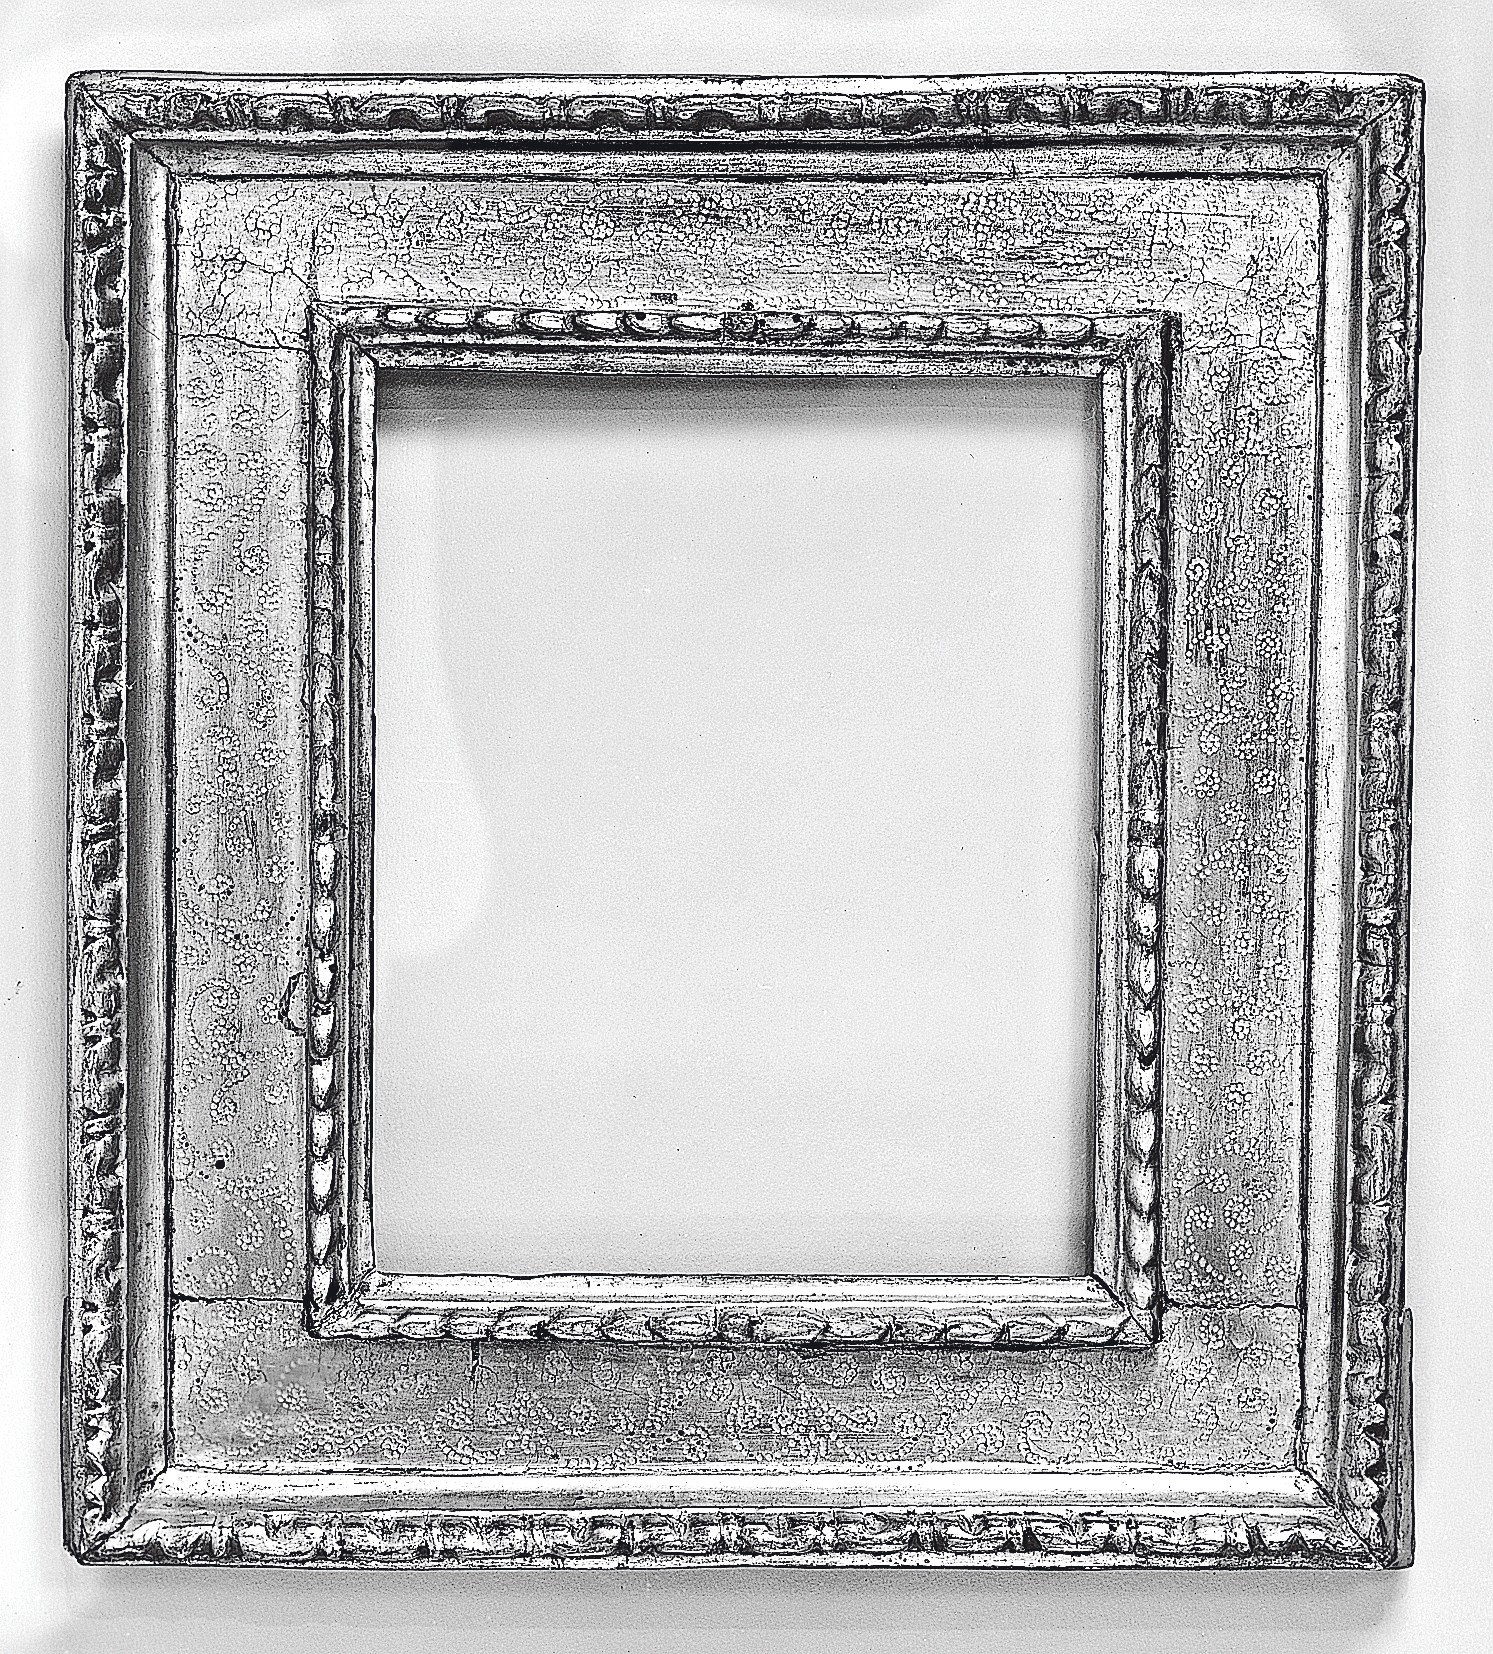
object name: frame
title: Cassetta frame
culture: italian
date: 1567-1600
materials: wood